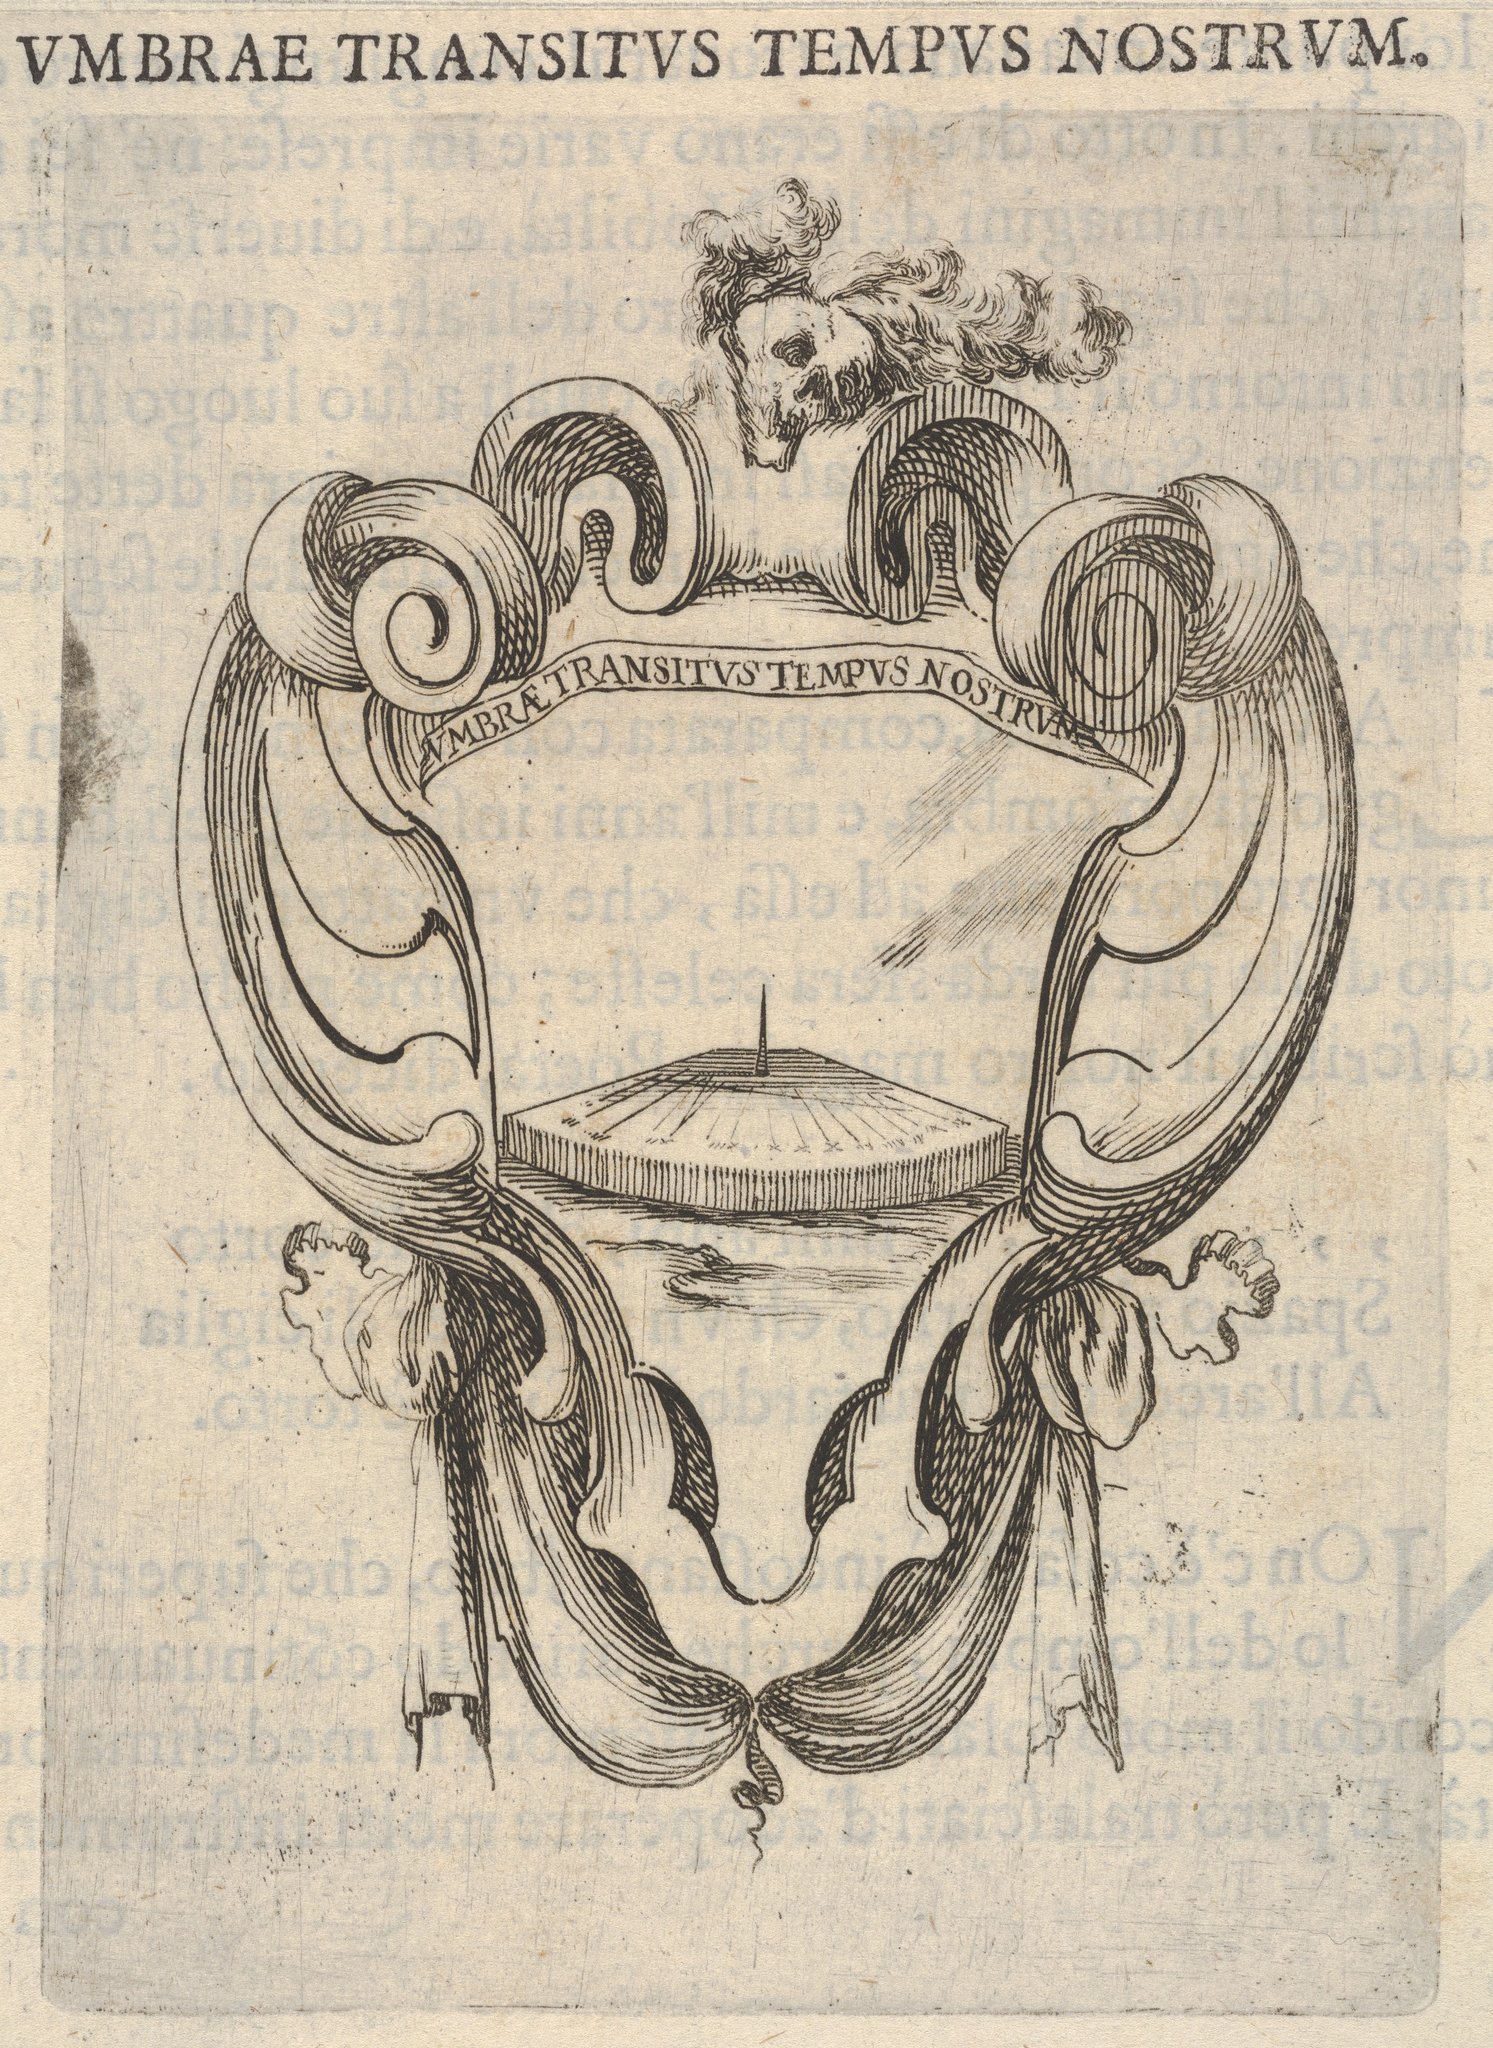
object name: print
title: A cartouche with a sundial, a skull with feathers on its head at top, from "Eight Emblems for the Funeral of Francesco de Medici" (Huit emblèmes pour les funérailles du prince François de Médicis)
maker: stefano della bella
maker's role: artist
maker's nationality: italian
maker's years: 1610-1664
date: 1640-1660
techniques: etching, letterpress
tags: cartouches,skulls,feathers,sundials